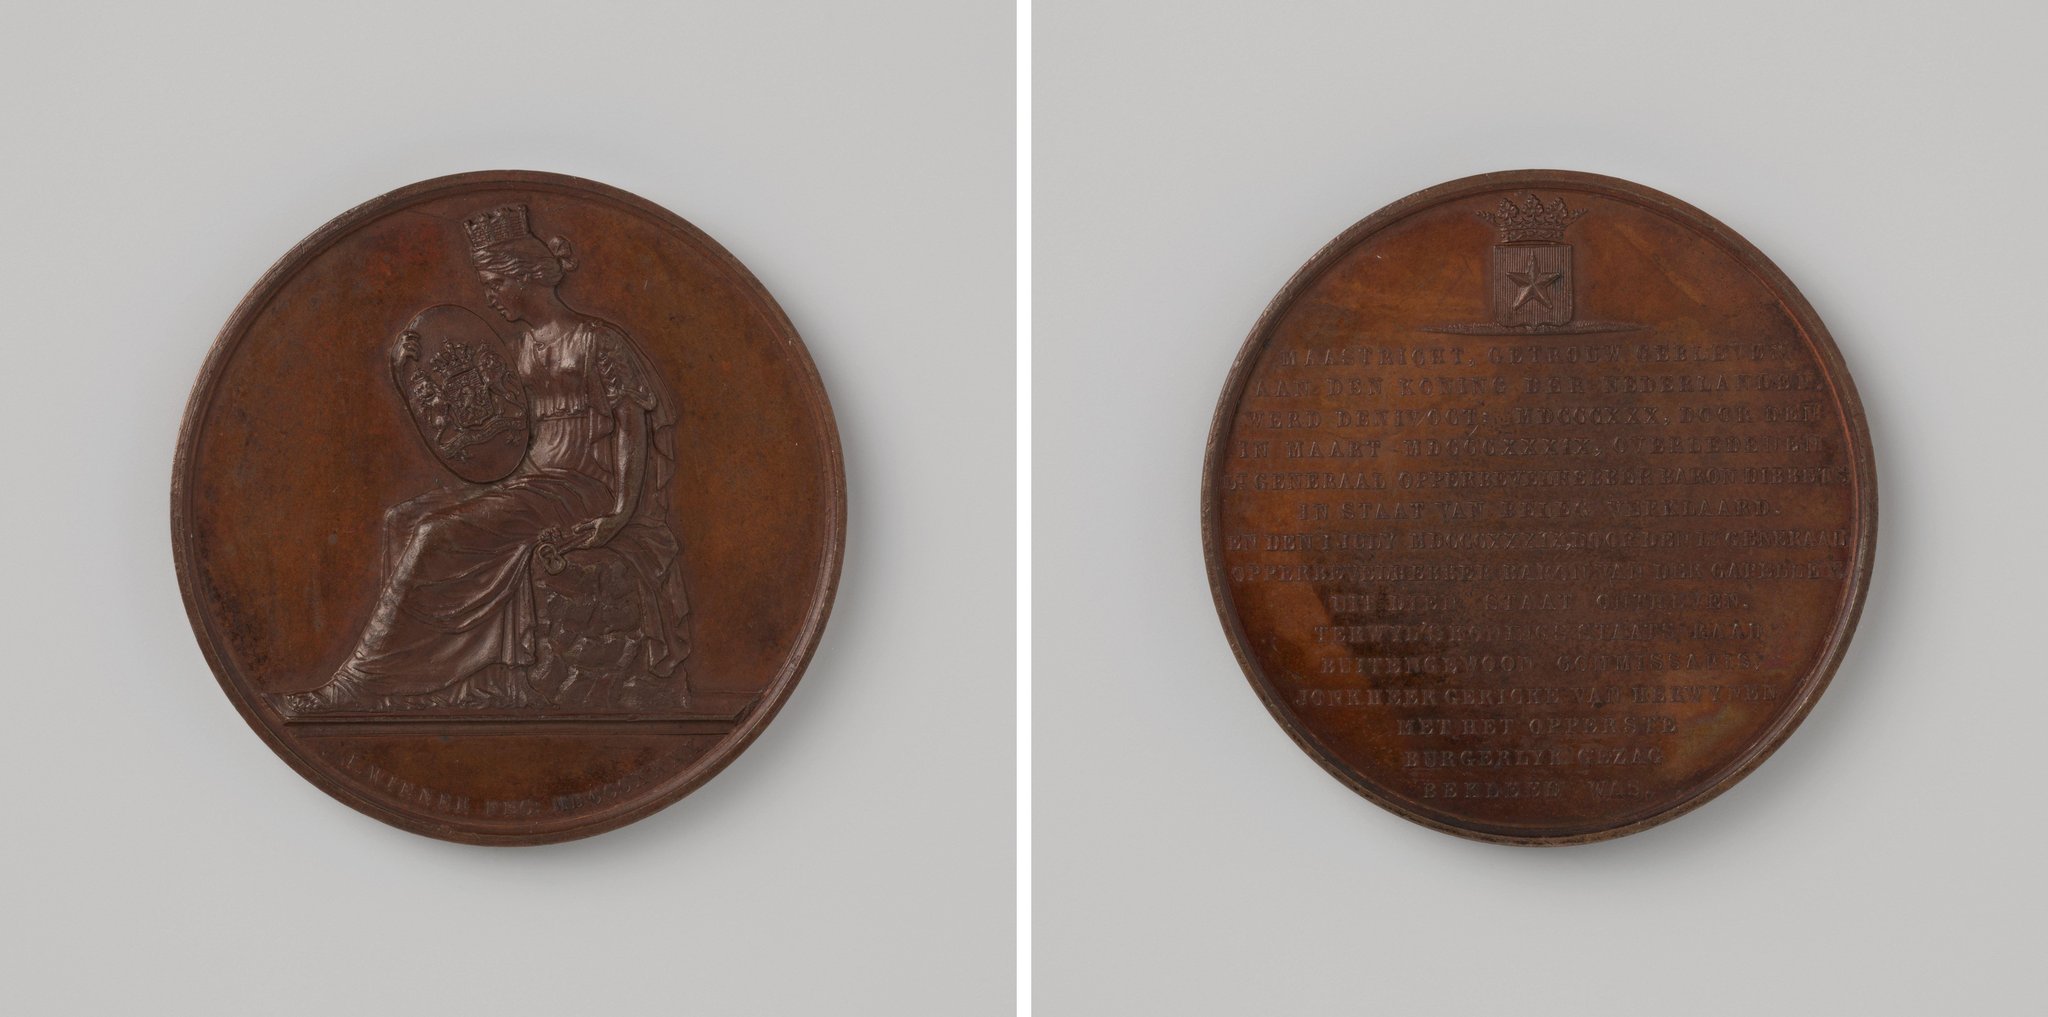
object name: history medal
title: Opheffen van de staat van beleg van Maastricht 1839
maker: jacob wiener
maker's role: medailleur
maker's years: 1815-1899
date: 1839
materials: bronze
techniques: striking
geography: brussels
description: Bronzen penning, op de voorzijde een naar links zittende stadsgodin met sleutels en ovalen schild met het Nederlandse wapen, met afsnedetekst, op de keerzijde vijftien regels tekst onder een klein gekroond Maastrichts wapenschild.